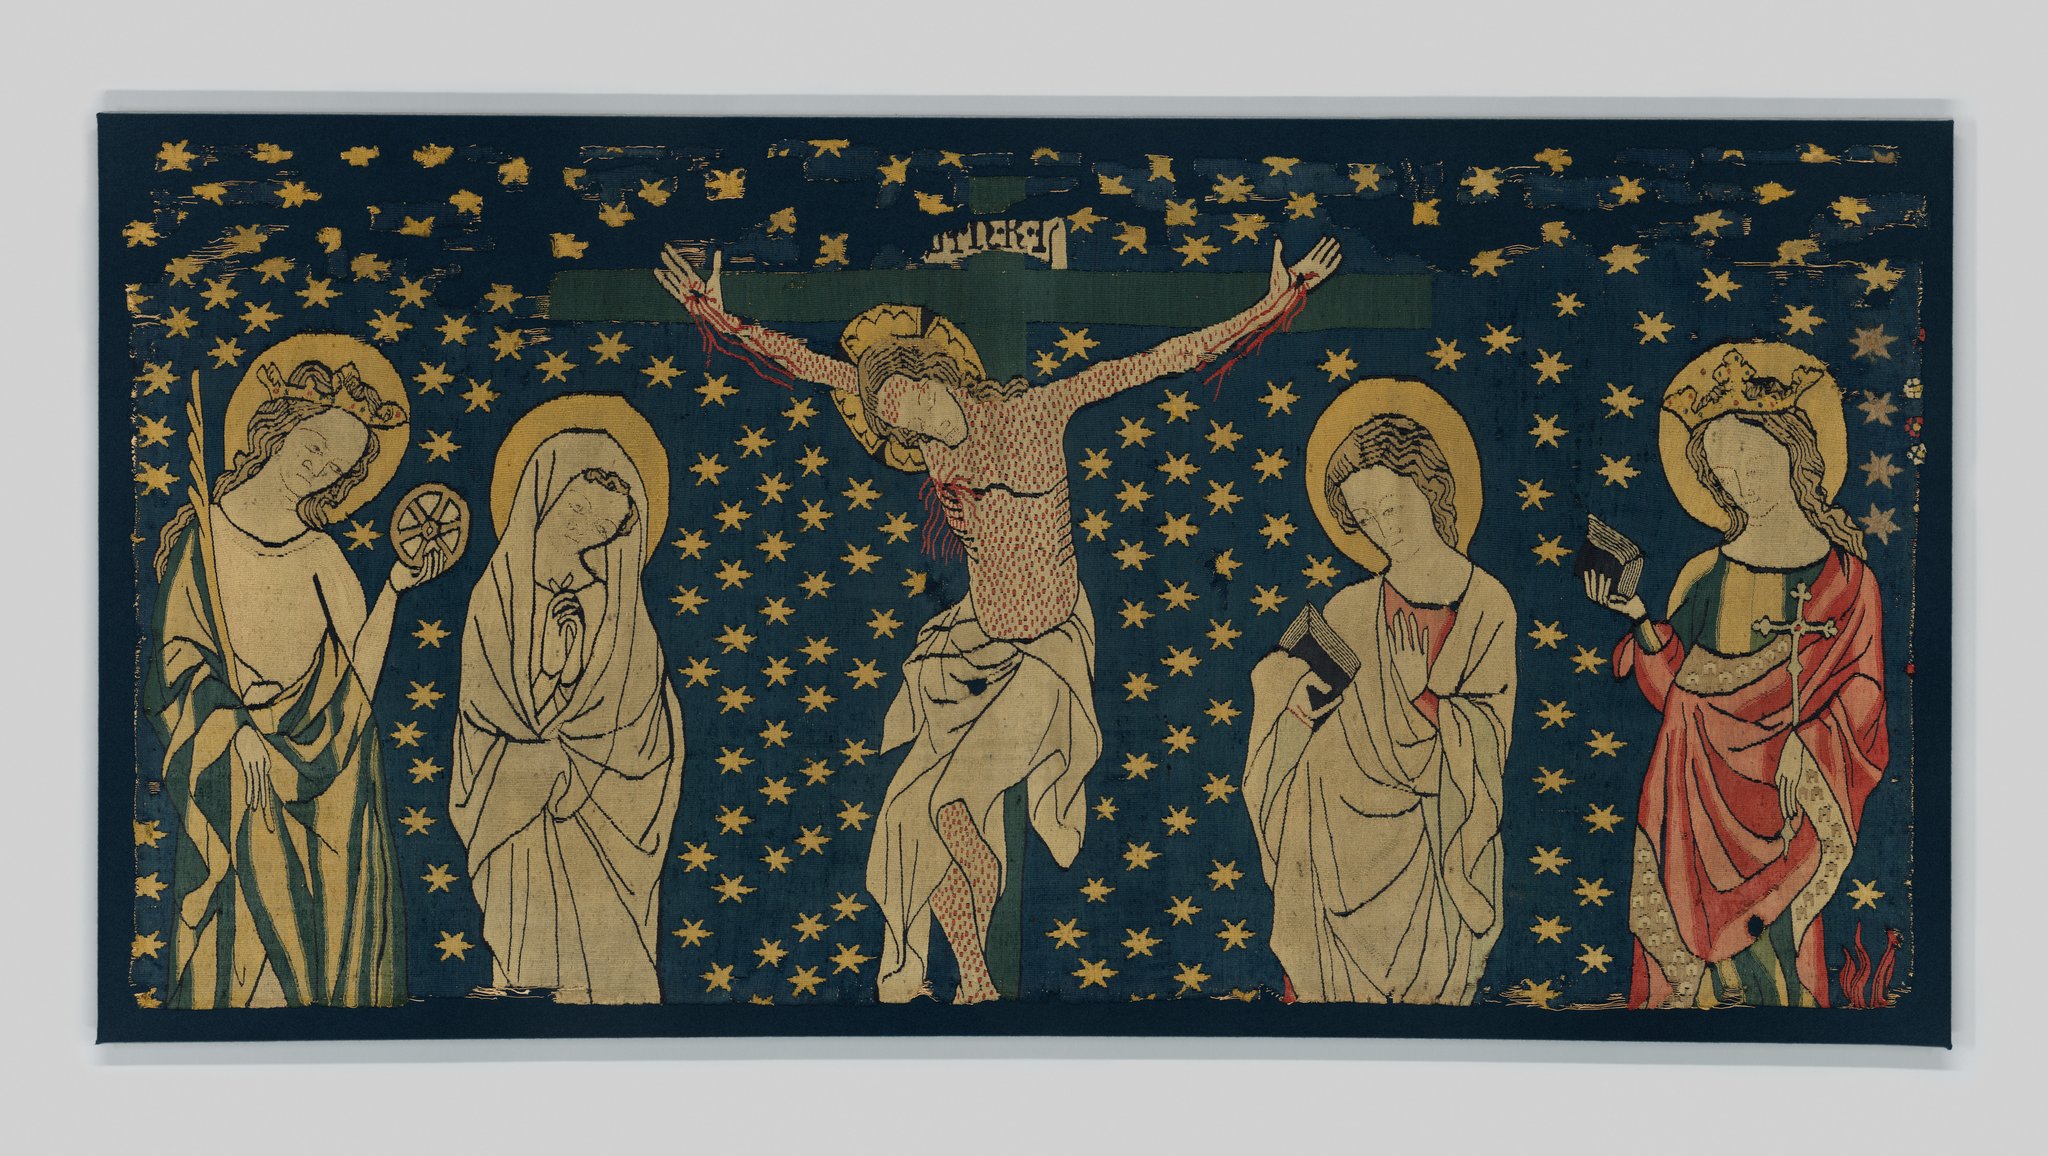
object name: crucifix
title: Crucifixion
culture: german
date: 1325-1350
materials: linen, silk, wool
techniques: embroidery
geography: constance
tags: christ,saint john the evangelist,virgin mary,crucifixion